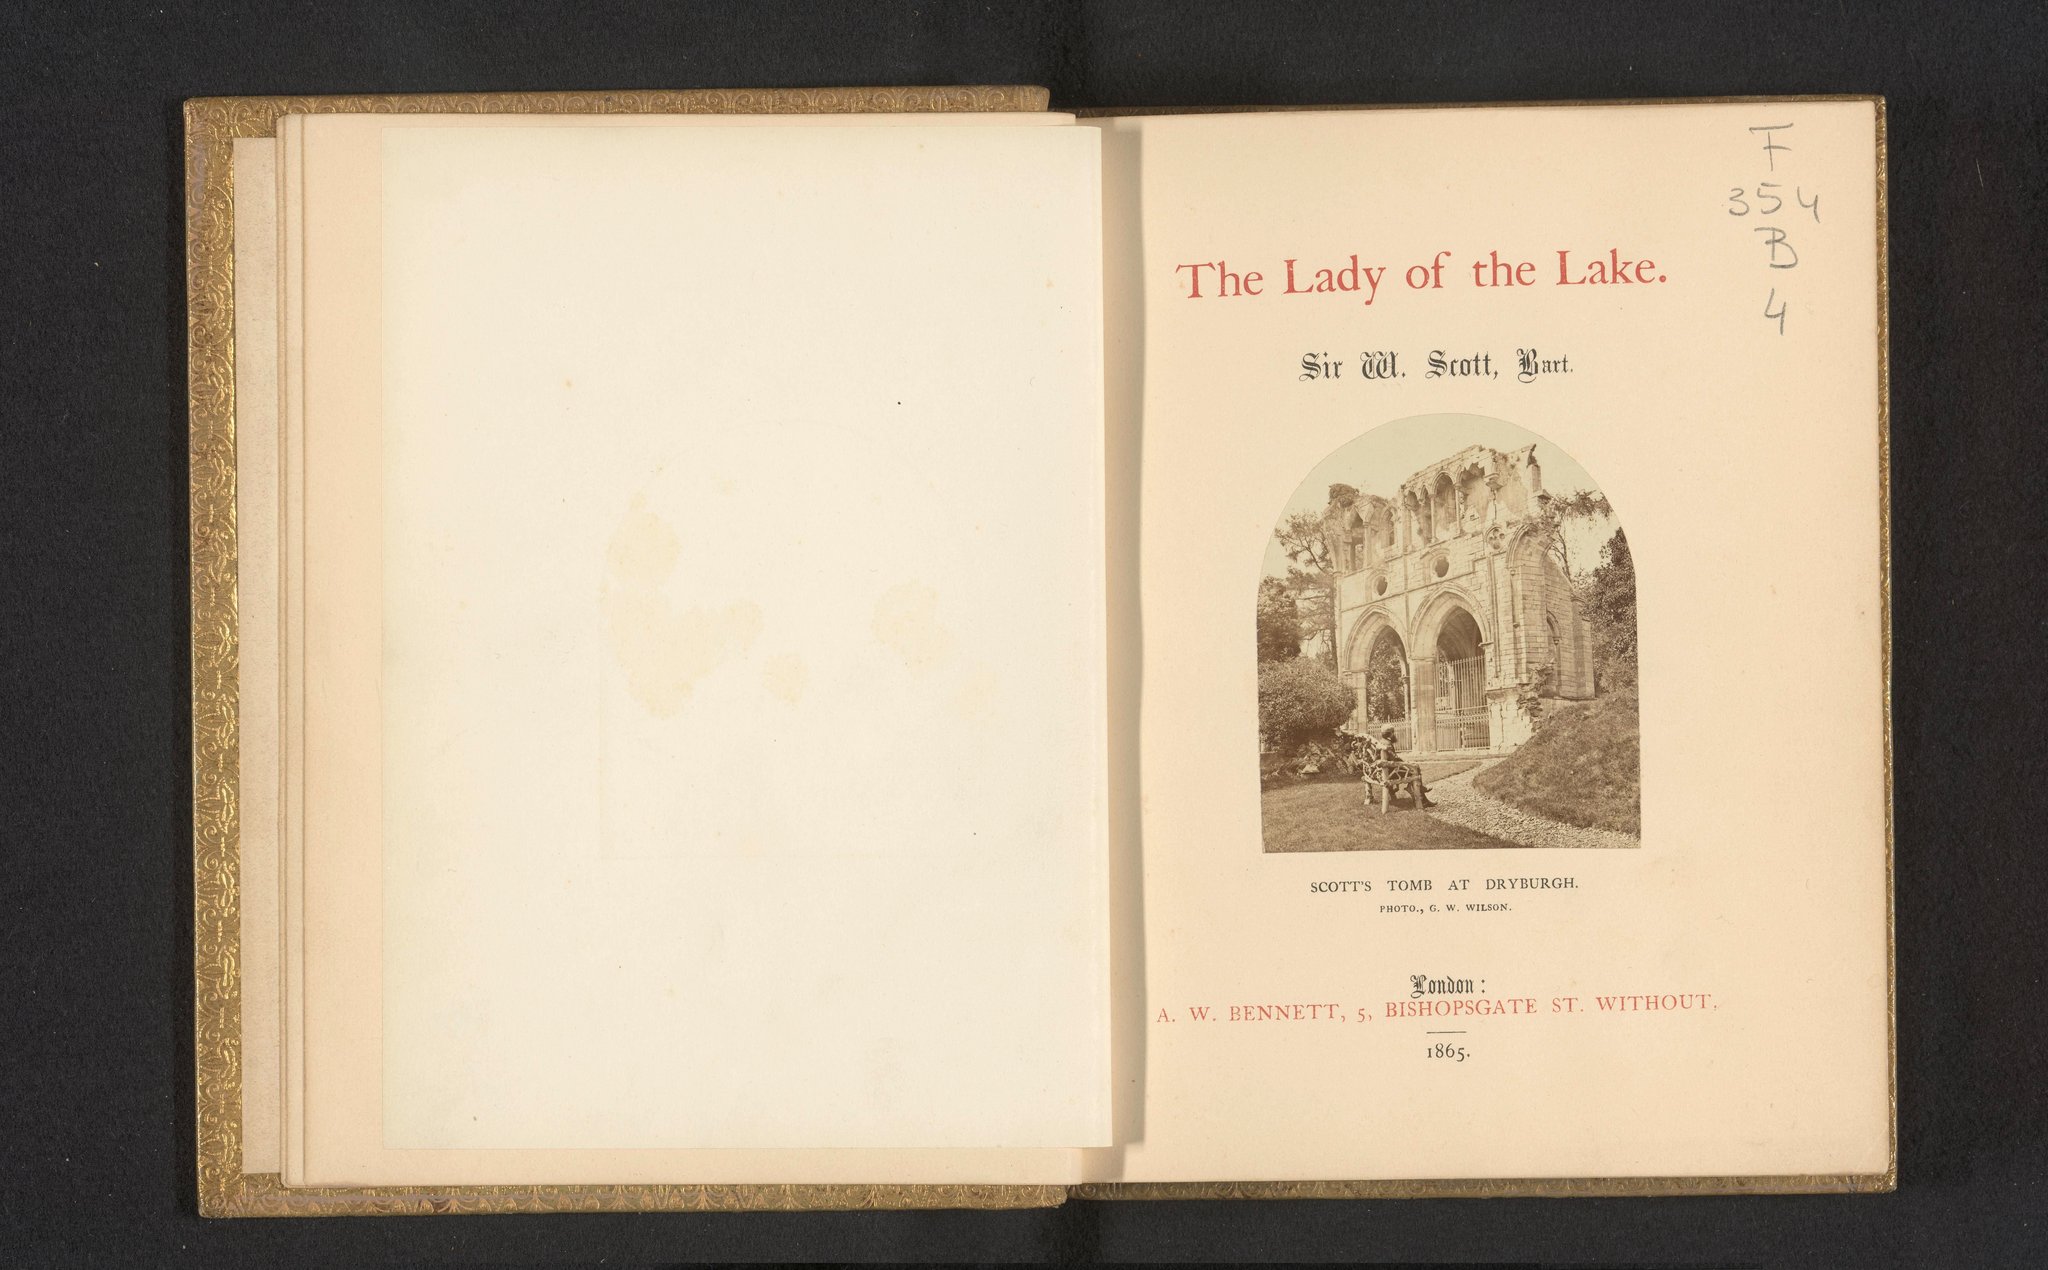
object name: photograph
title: Scott's tomb at Dryburgh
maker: george washington wilson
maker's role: publisher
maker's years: 1823-1893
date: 1855-1865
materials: photographic support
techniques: albumen print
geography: dryburgh abbey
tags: walter scott, grave, tomb